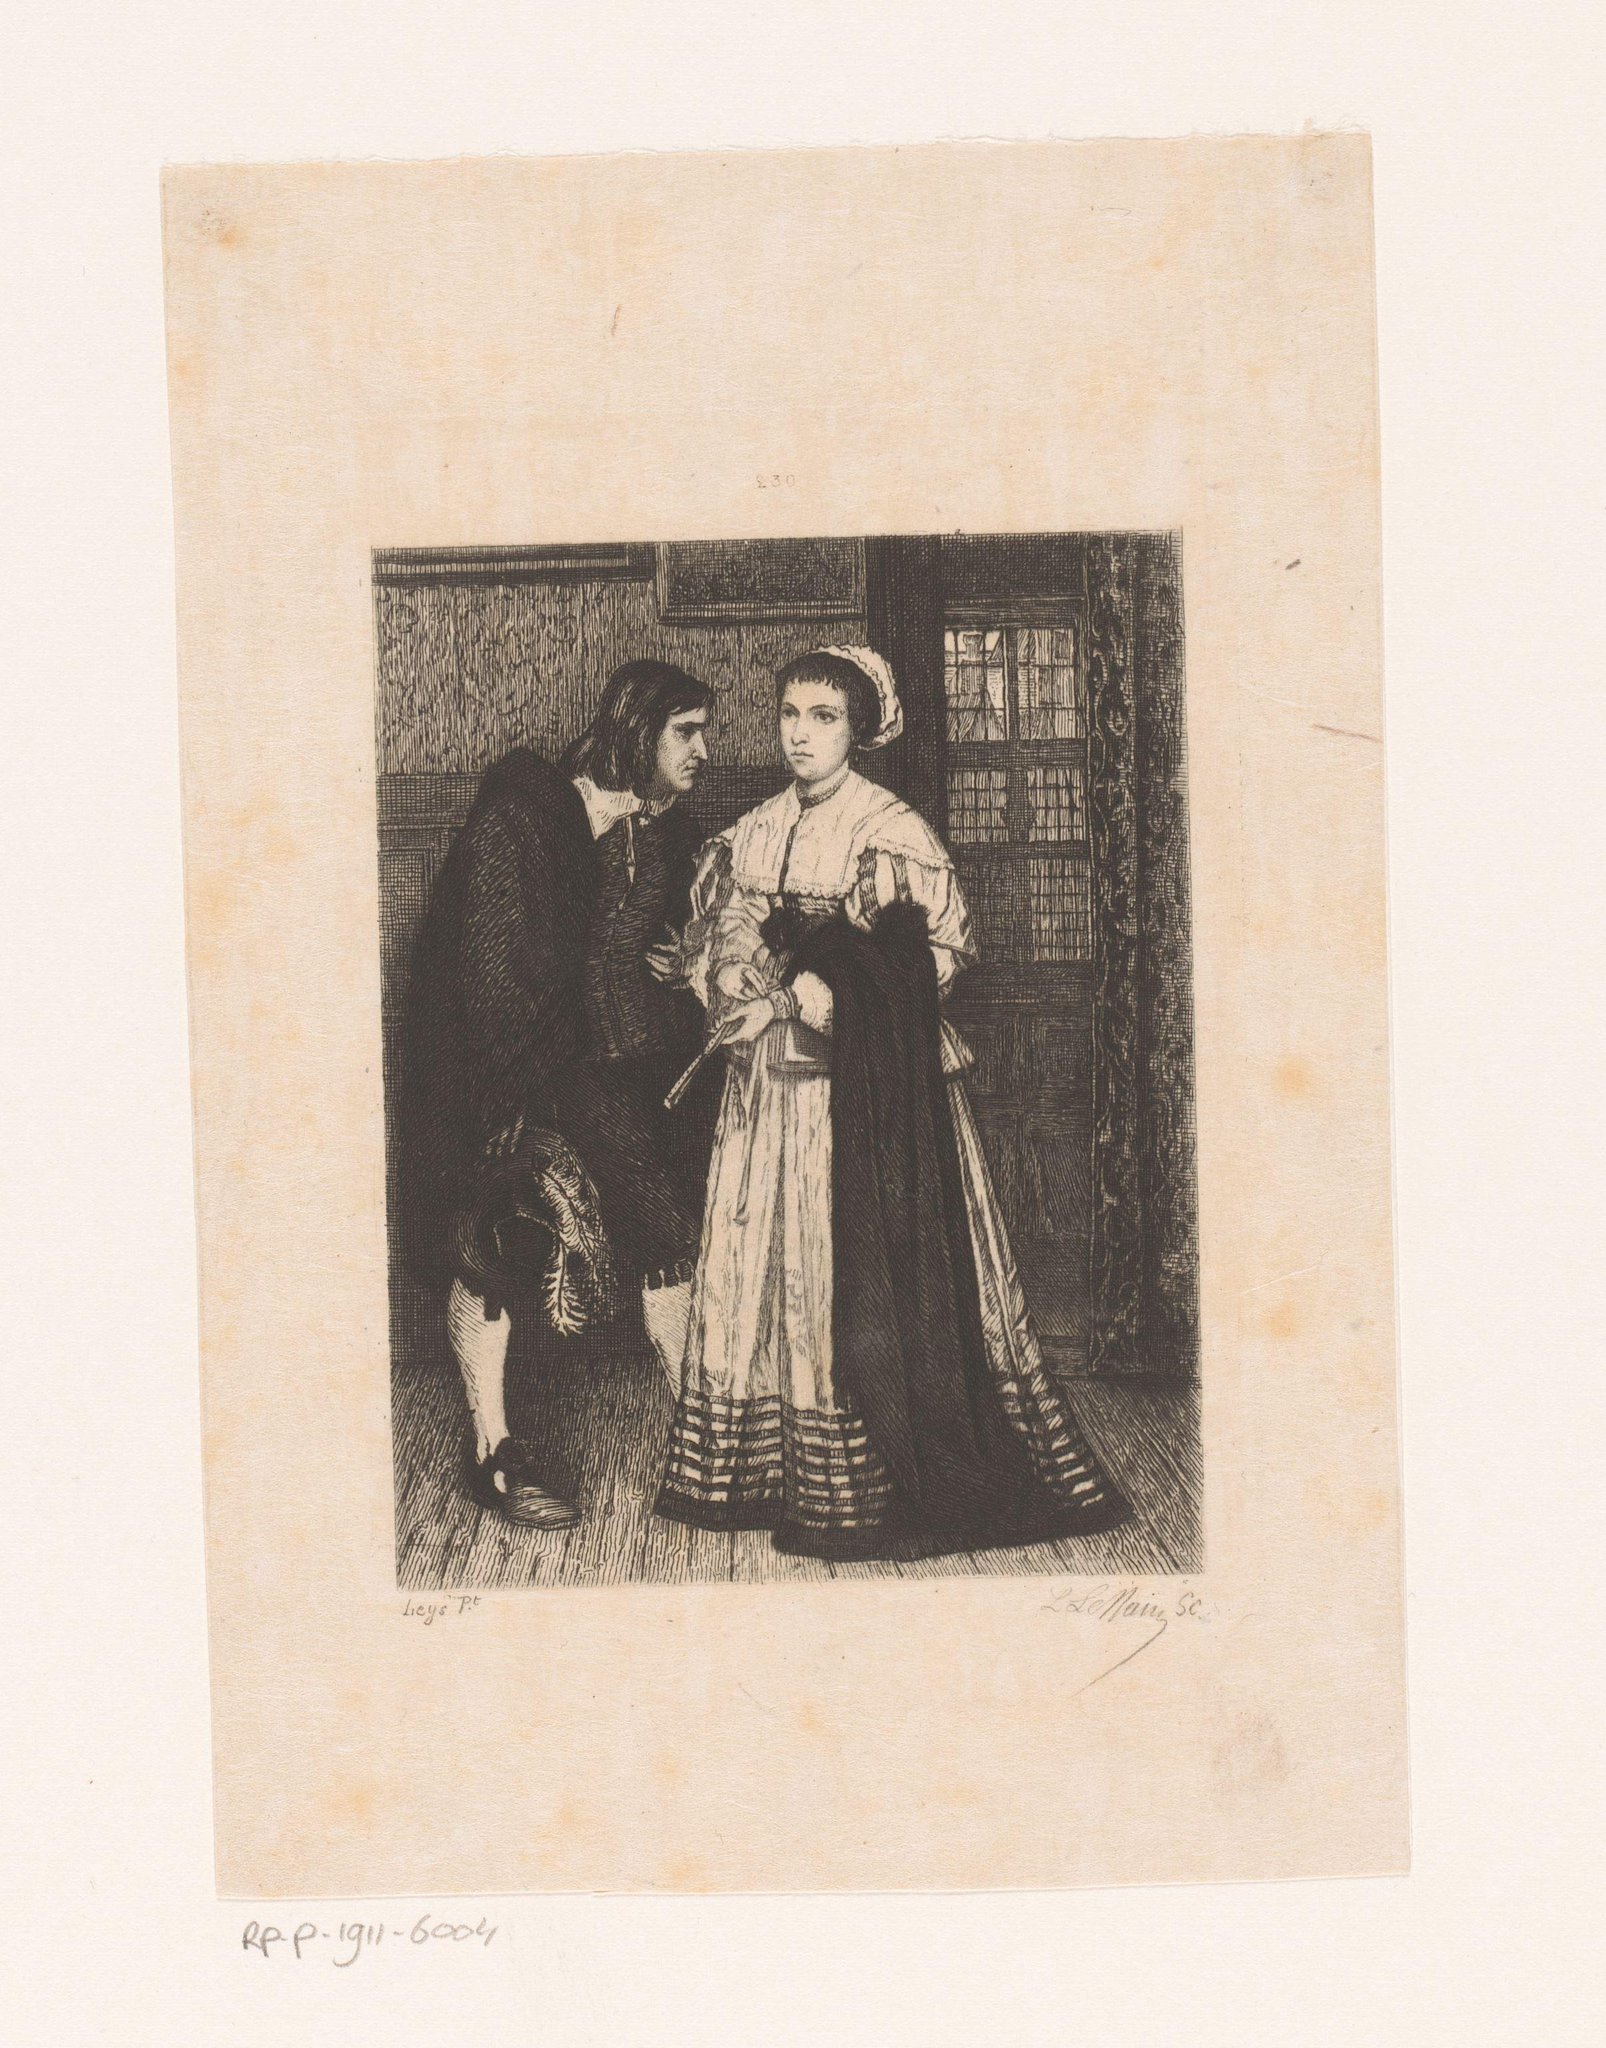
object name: print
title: La déclaration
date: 1863-1911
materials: paper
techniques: drypoint, etching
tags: adult woman, adult man, historical costume, proposal, declaration of love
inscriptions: collector's mark: Lugt 2228